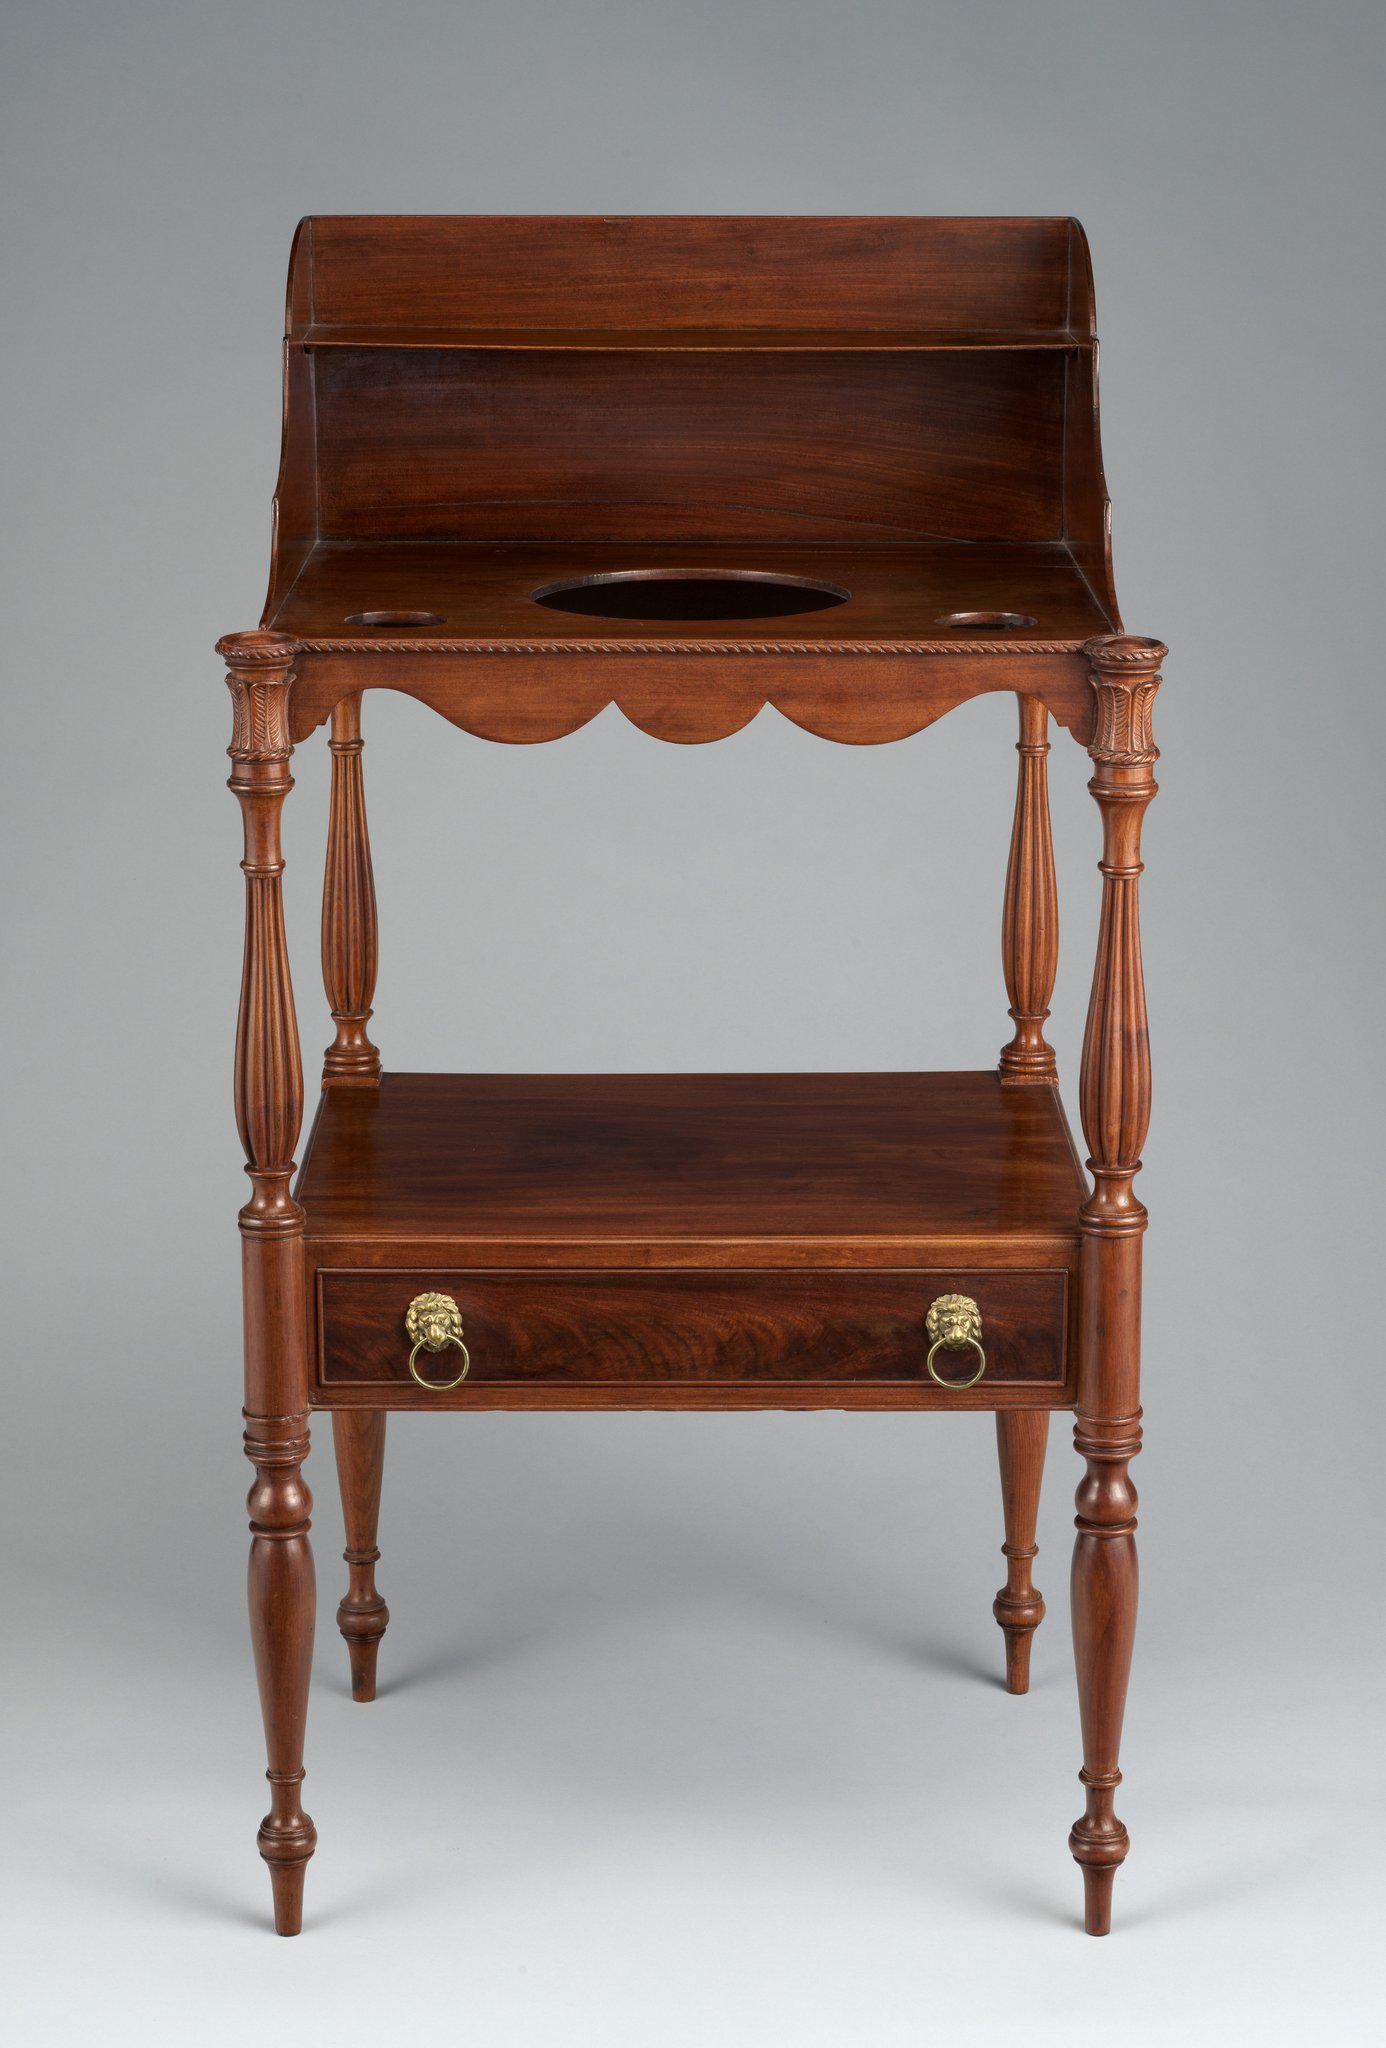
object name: basin stand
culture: american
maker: william hook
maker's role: maker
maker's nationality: american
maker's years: 1777-1867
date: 1810-1815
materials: wood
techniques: veneering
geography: united states